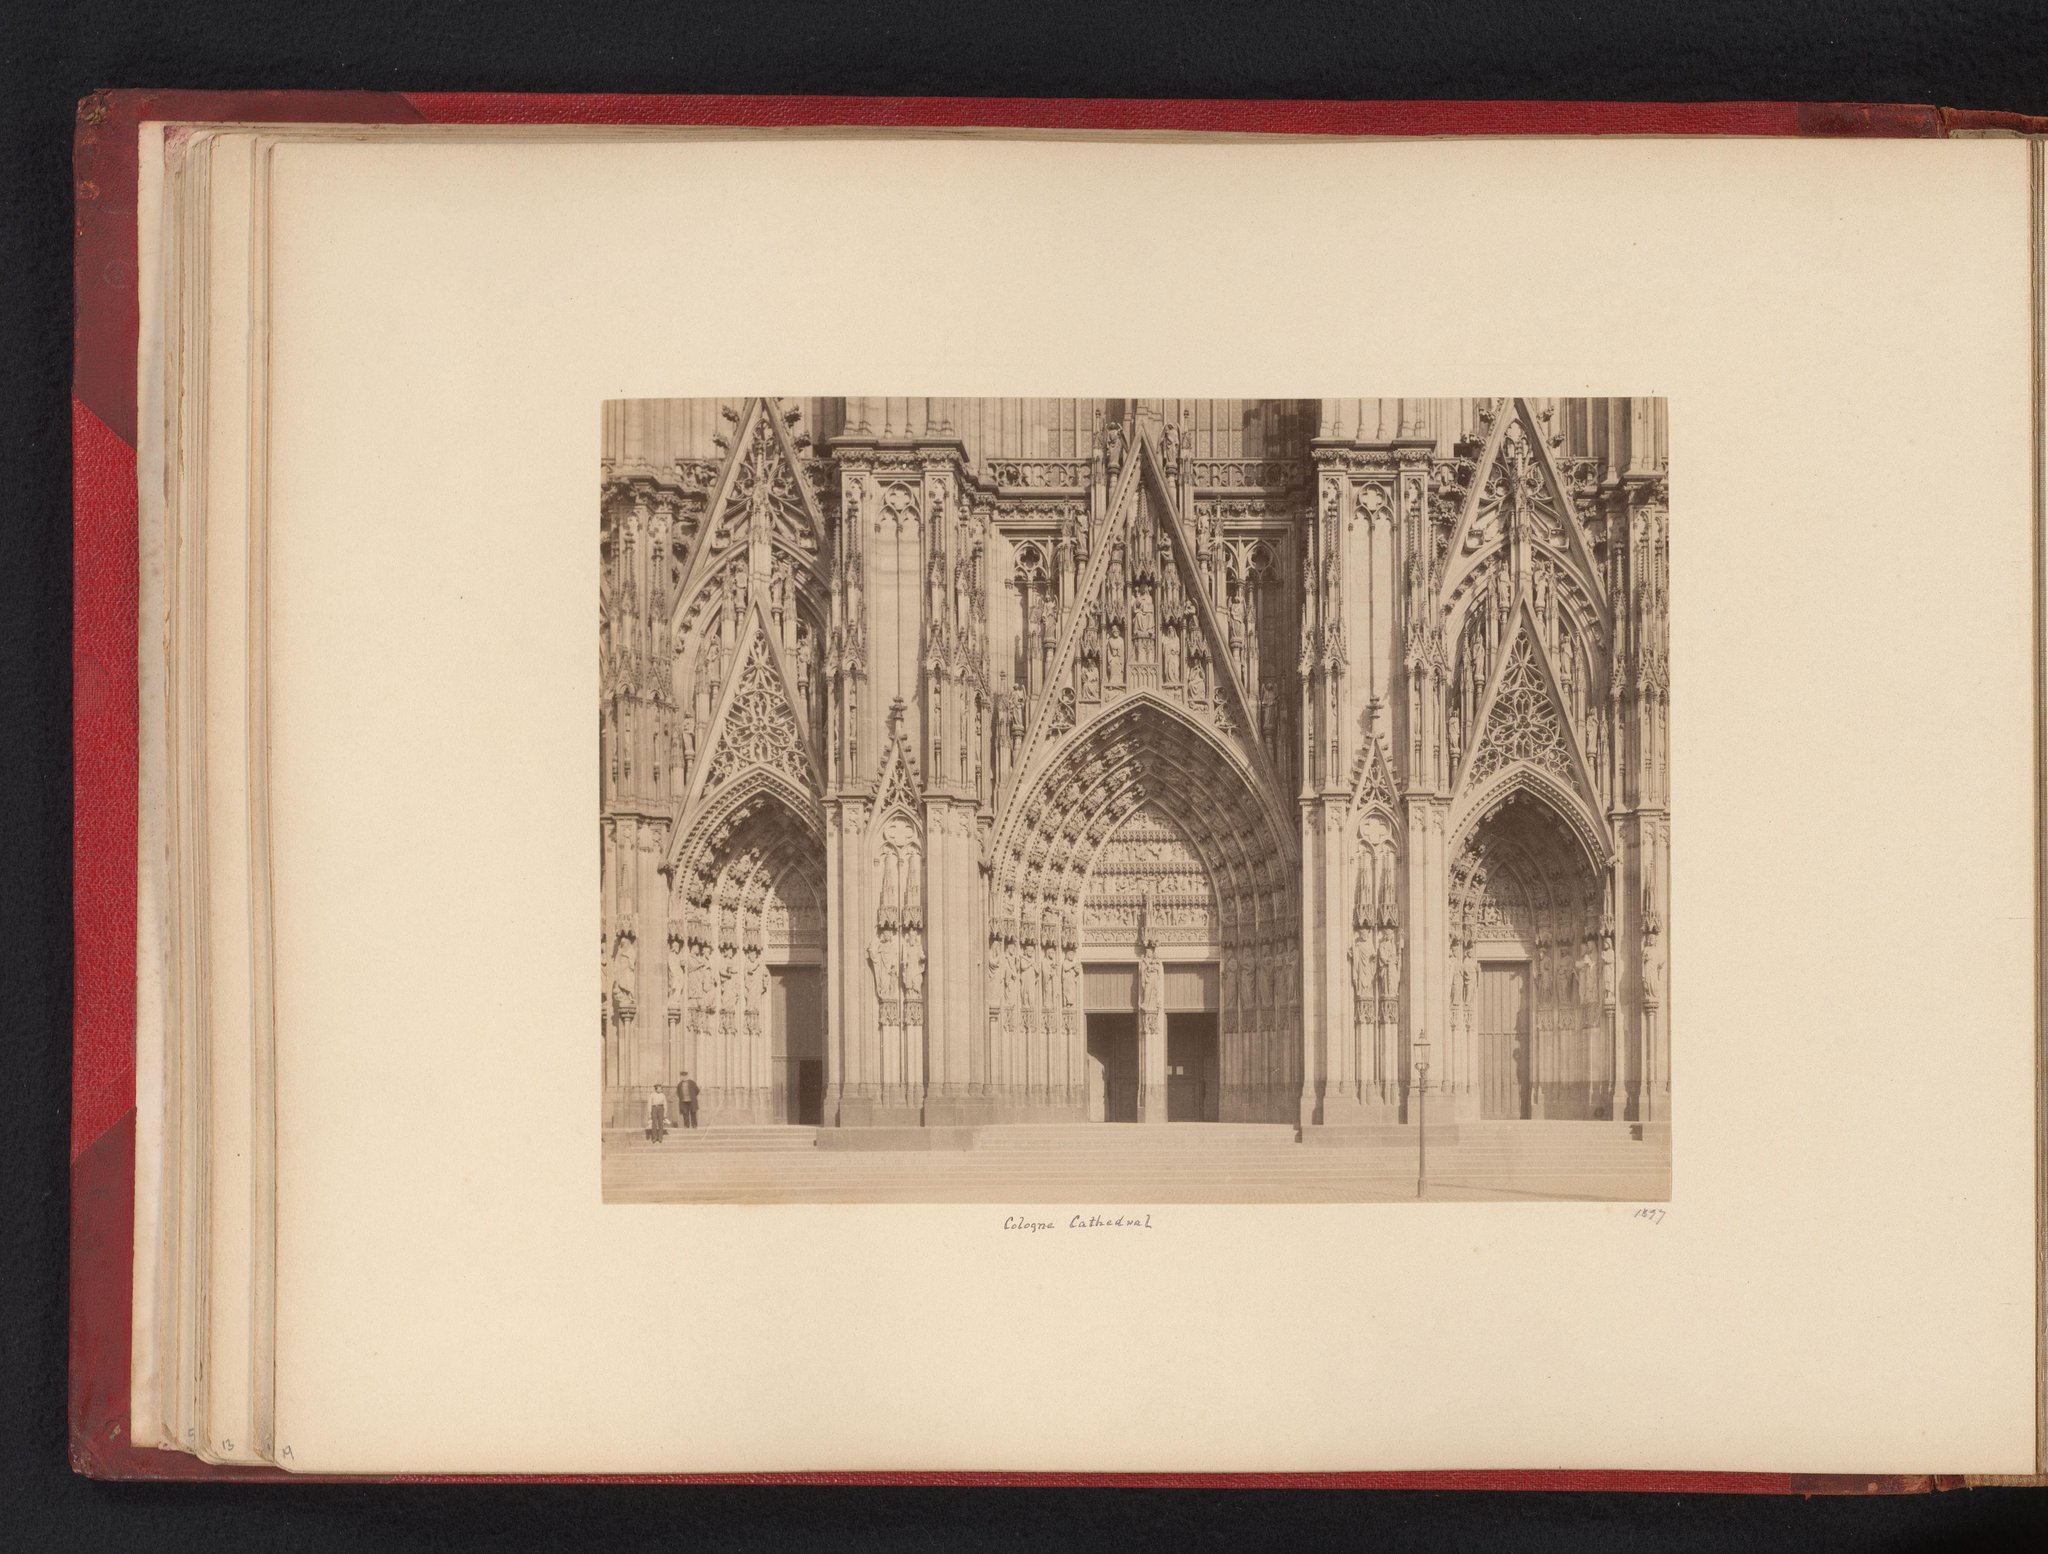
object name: photograph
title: Gezicht op het portaal van de Dom van Keulen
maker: Anonymous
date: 1897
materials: cardboard, photographic support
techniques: albumen print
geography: cologne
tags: parts of church exterior and annexes: portal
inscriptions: annotation: ‘Cologne Cathedral 1897’